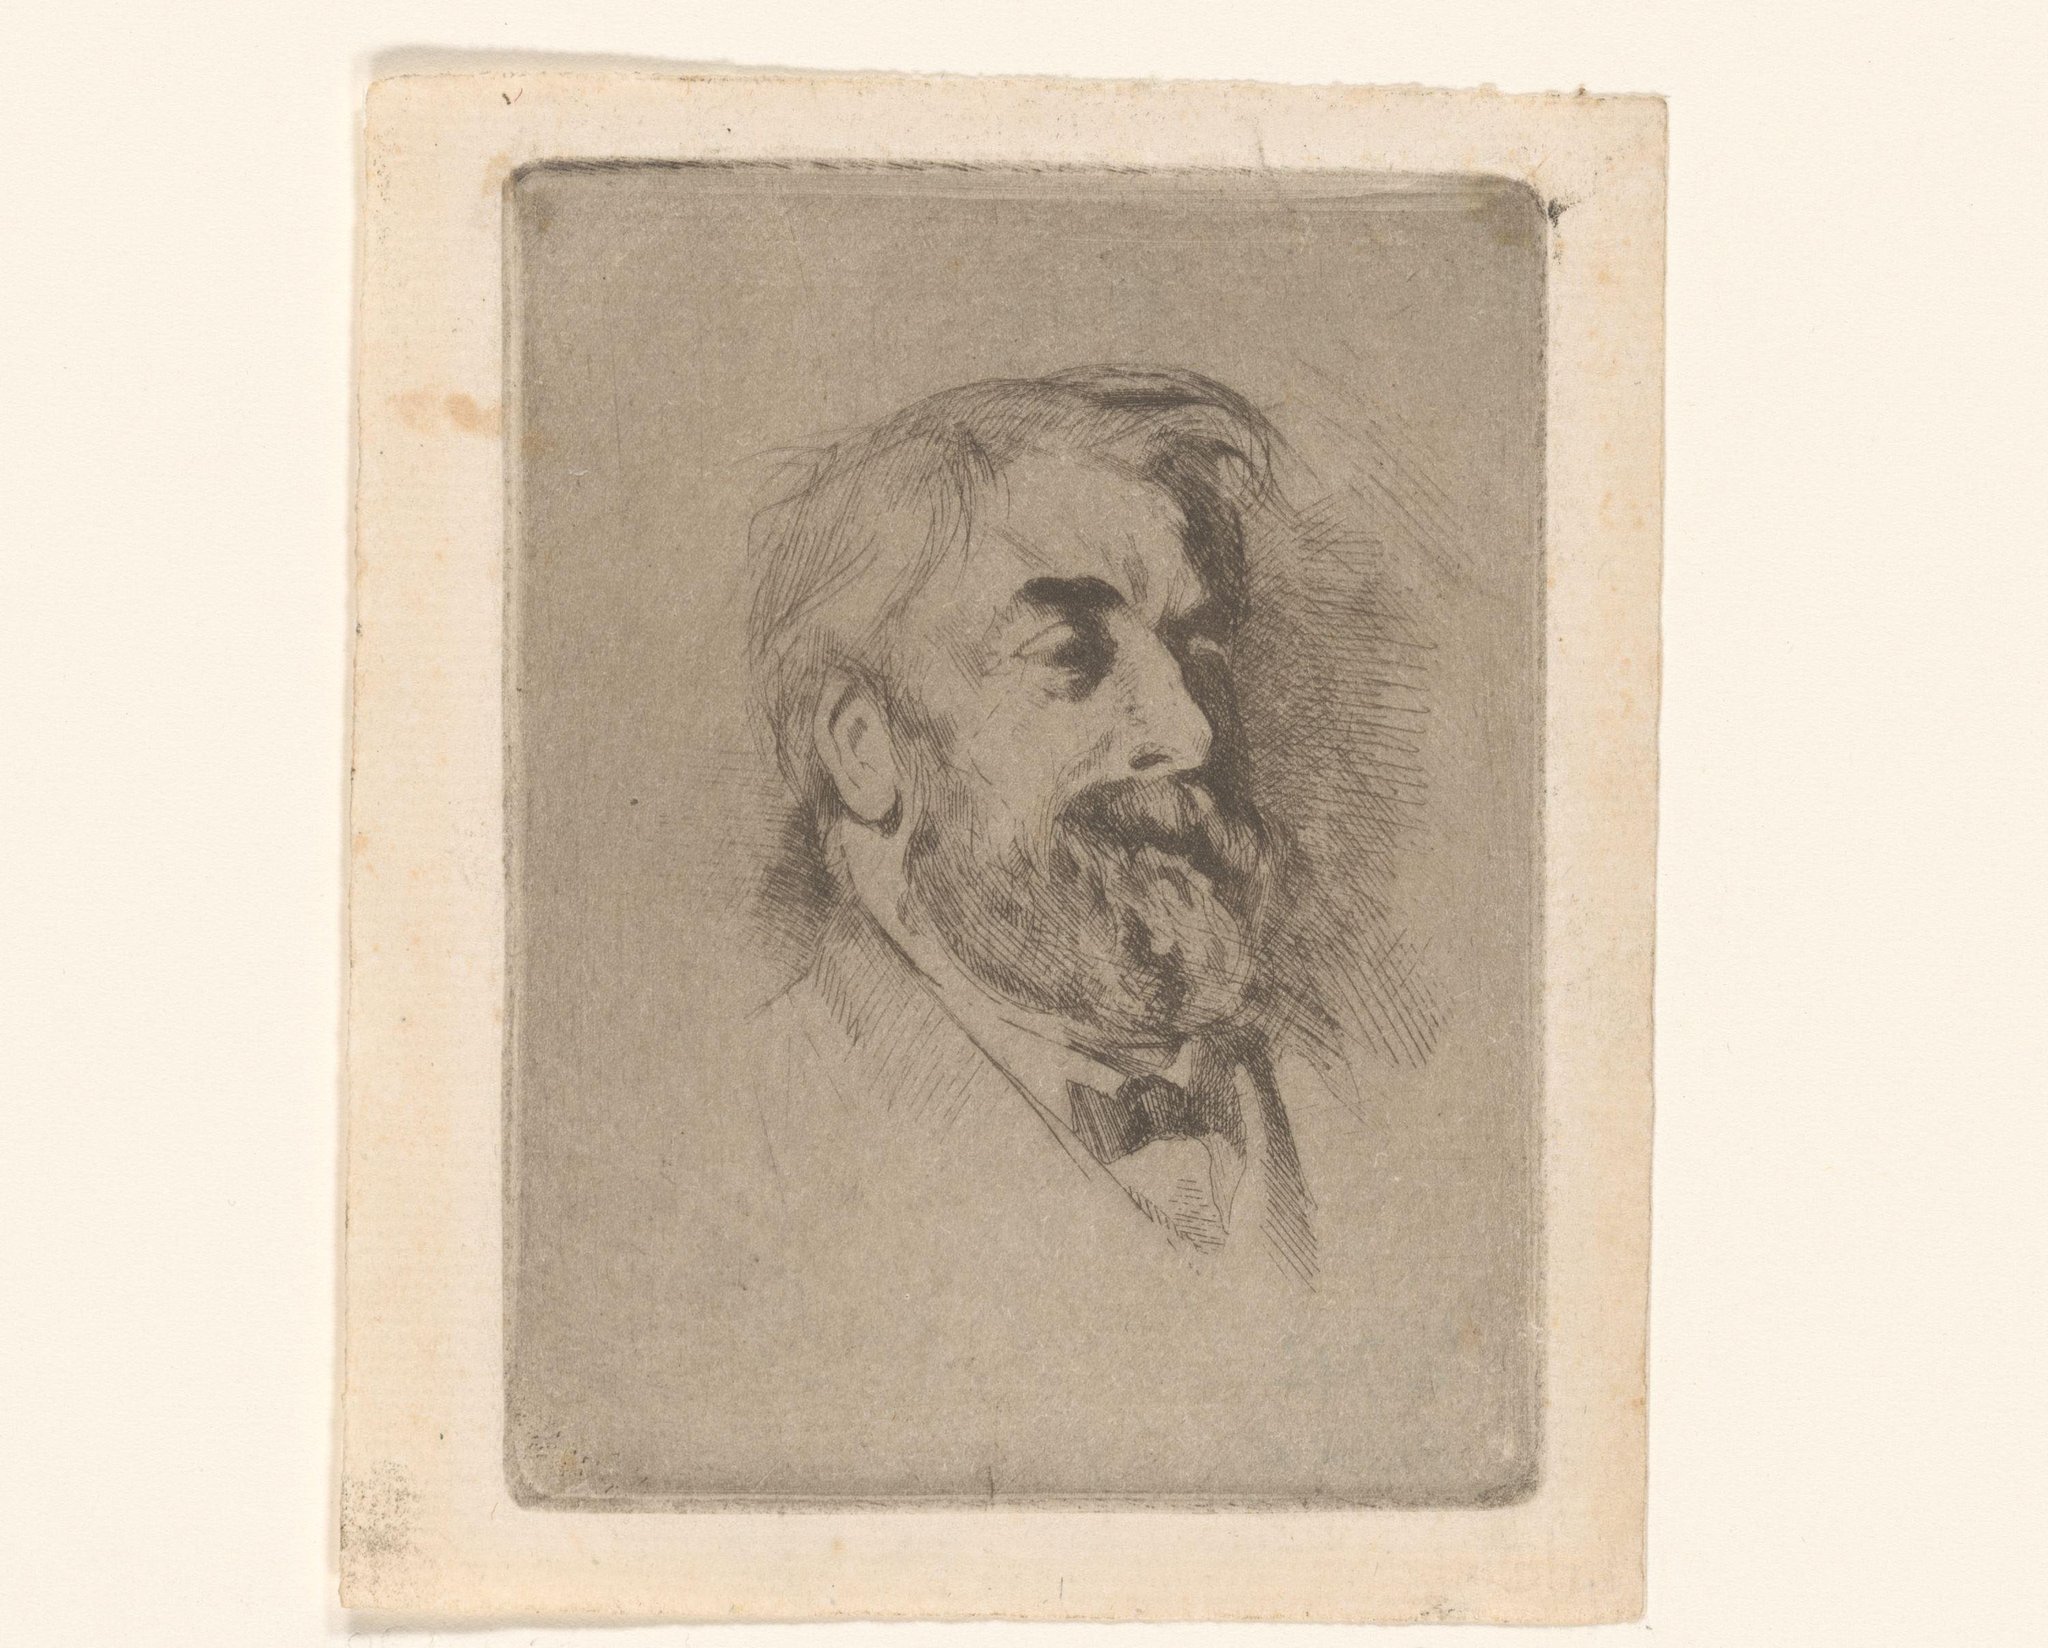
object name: print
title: Portret van Anton Mauve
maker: willem witsen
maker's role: draughtsman, painter, print maker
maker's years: 1860-1923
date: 1887-1888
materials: paper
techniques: etching, intaglio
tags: arnhem, anton mauve, historical persons